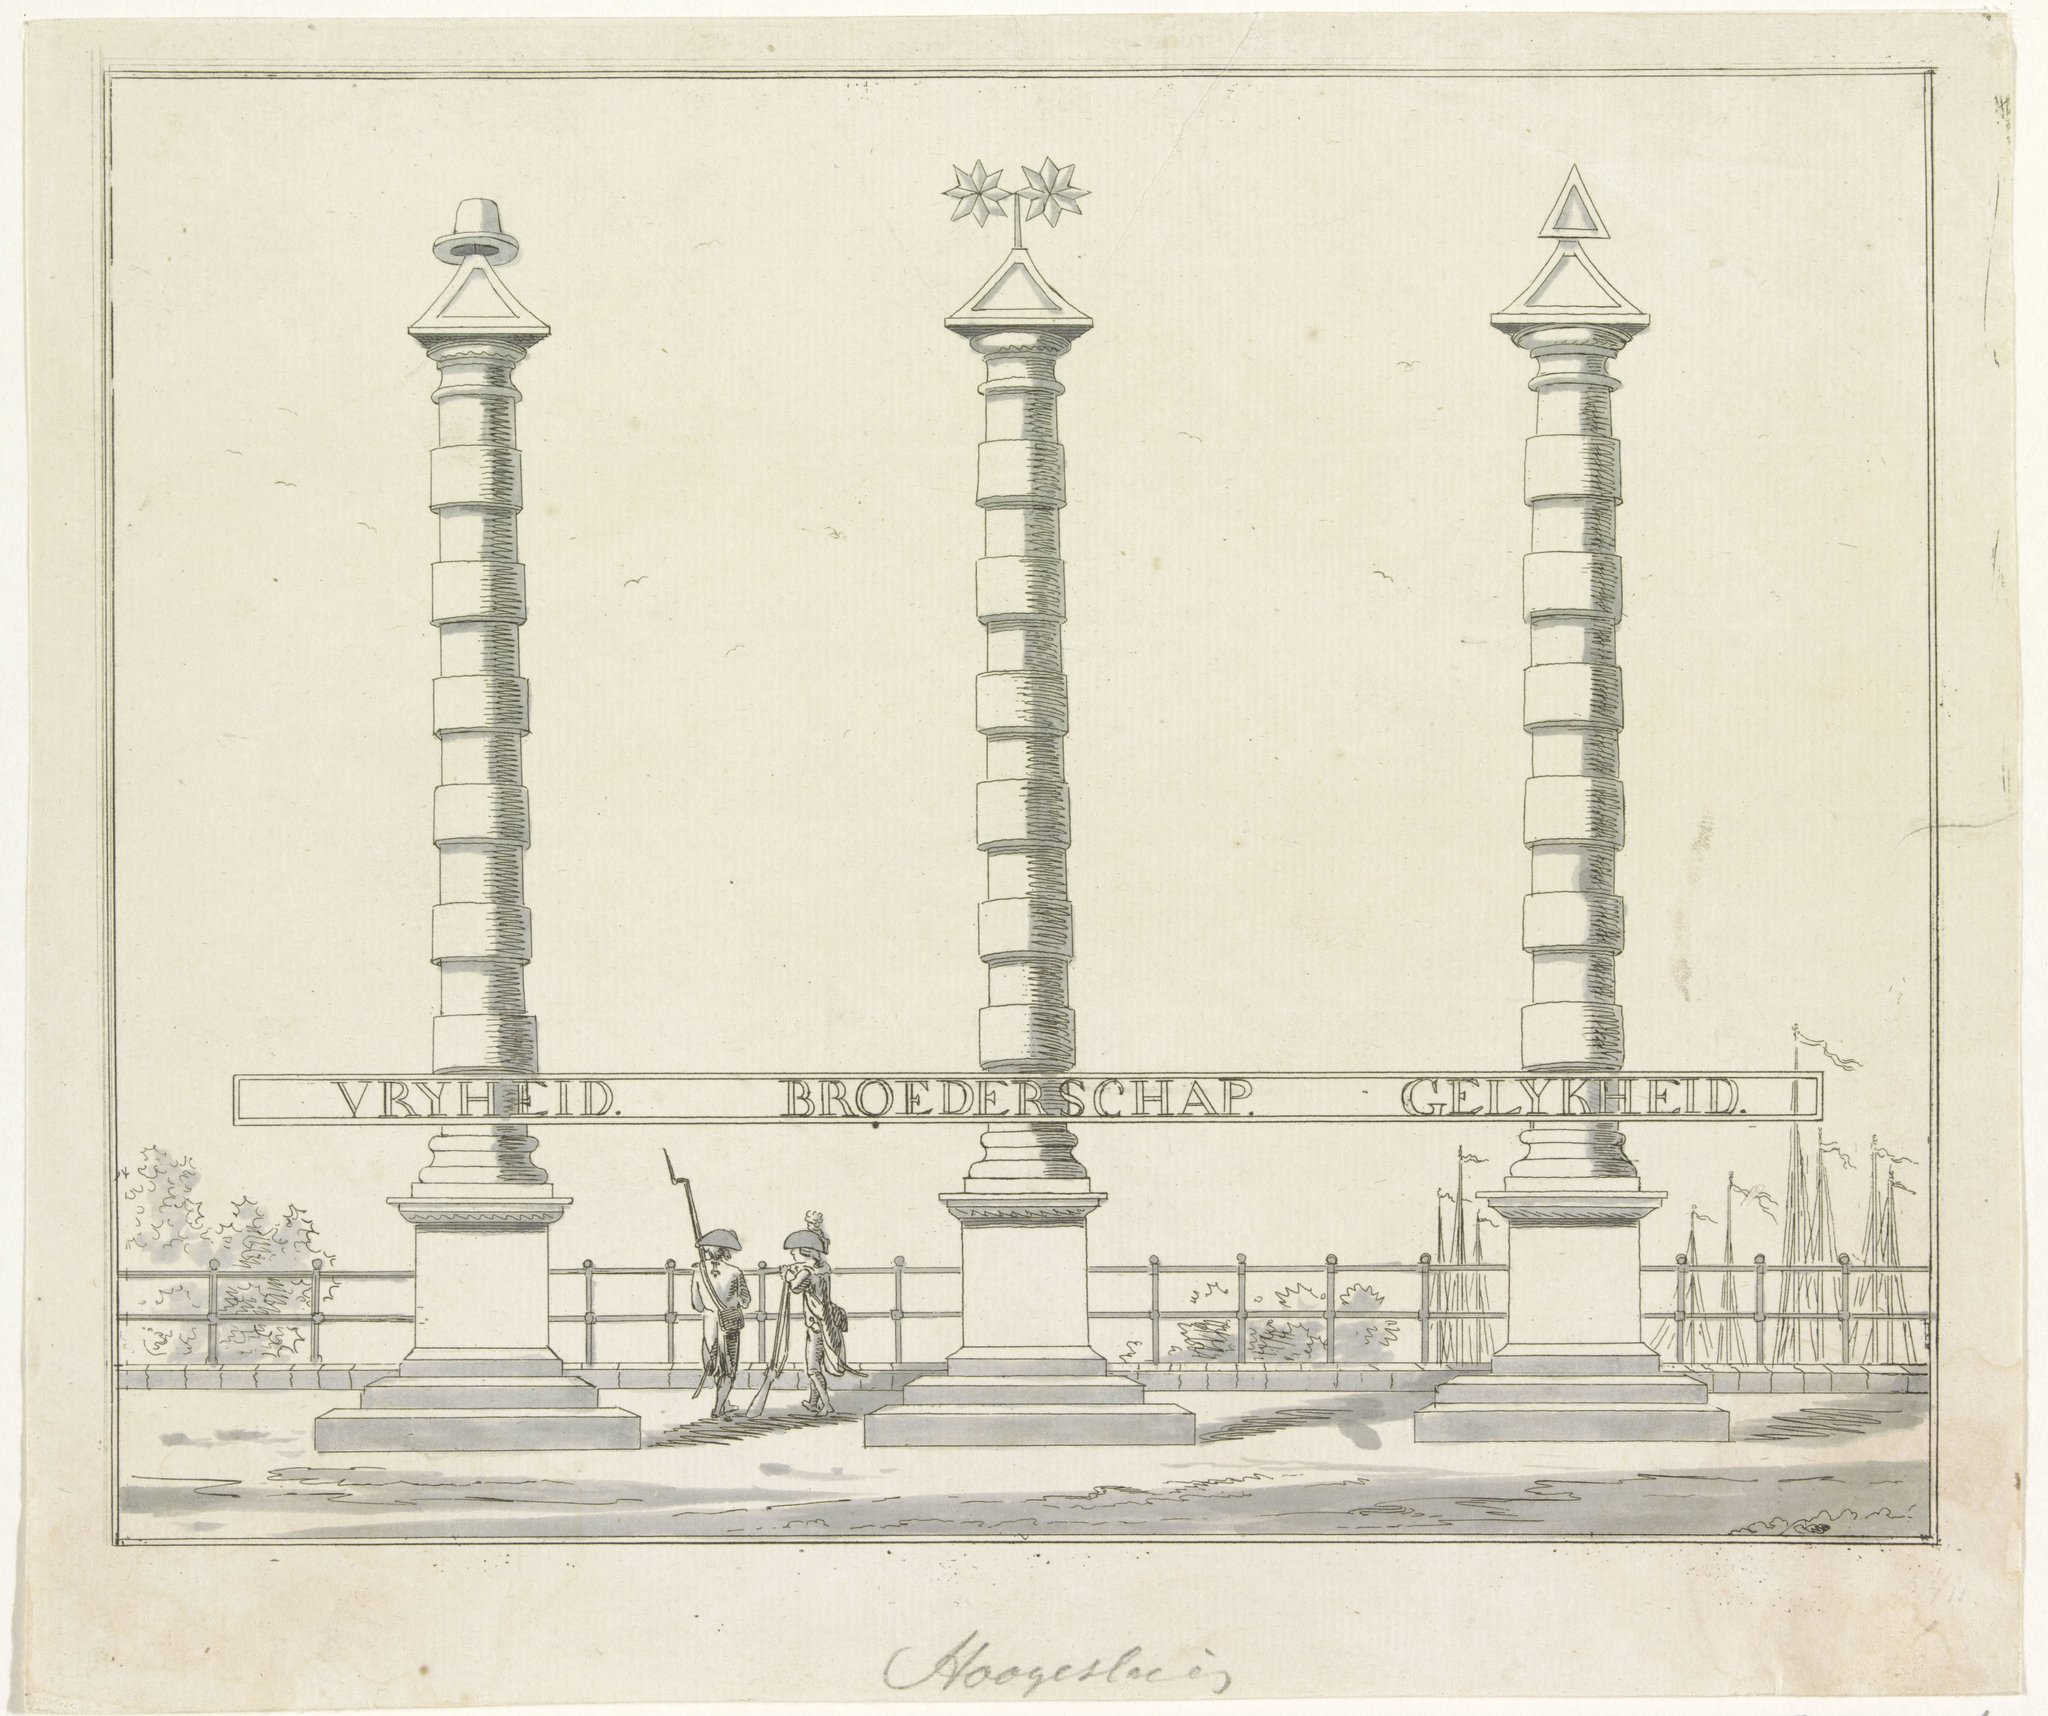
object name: print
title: Tien platen van de decoraties bij het Alliantiefeest te Amsterdam in 1795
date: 1795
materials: paper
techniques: brush, etching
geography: amsterdam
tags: festivities on events of national importance (+ festive decoration ~ festive activities), amsterdam, alliance with france (1795)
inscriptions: collector's mark: Lugt 2228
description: Drie zuilen voor Vrijheid, Broederschap en Gelijkheid, allegorische decoratie opgericht op de Hogesluis aan de Amstel te Amsterdam bij het Alliantiefeest op 19 juni 1795. Drie zuilen bekroond met de symbolen van Vrijheid, Broederschap en Gelijkheid. Onderdeel van een serie van tien platen.